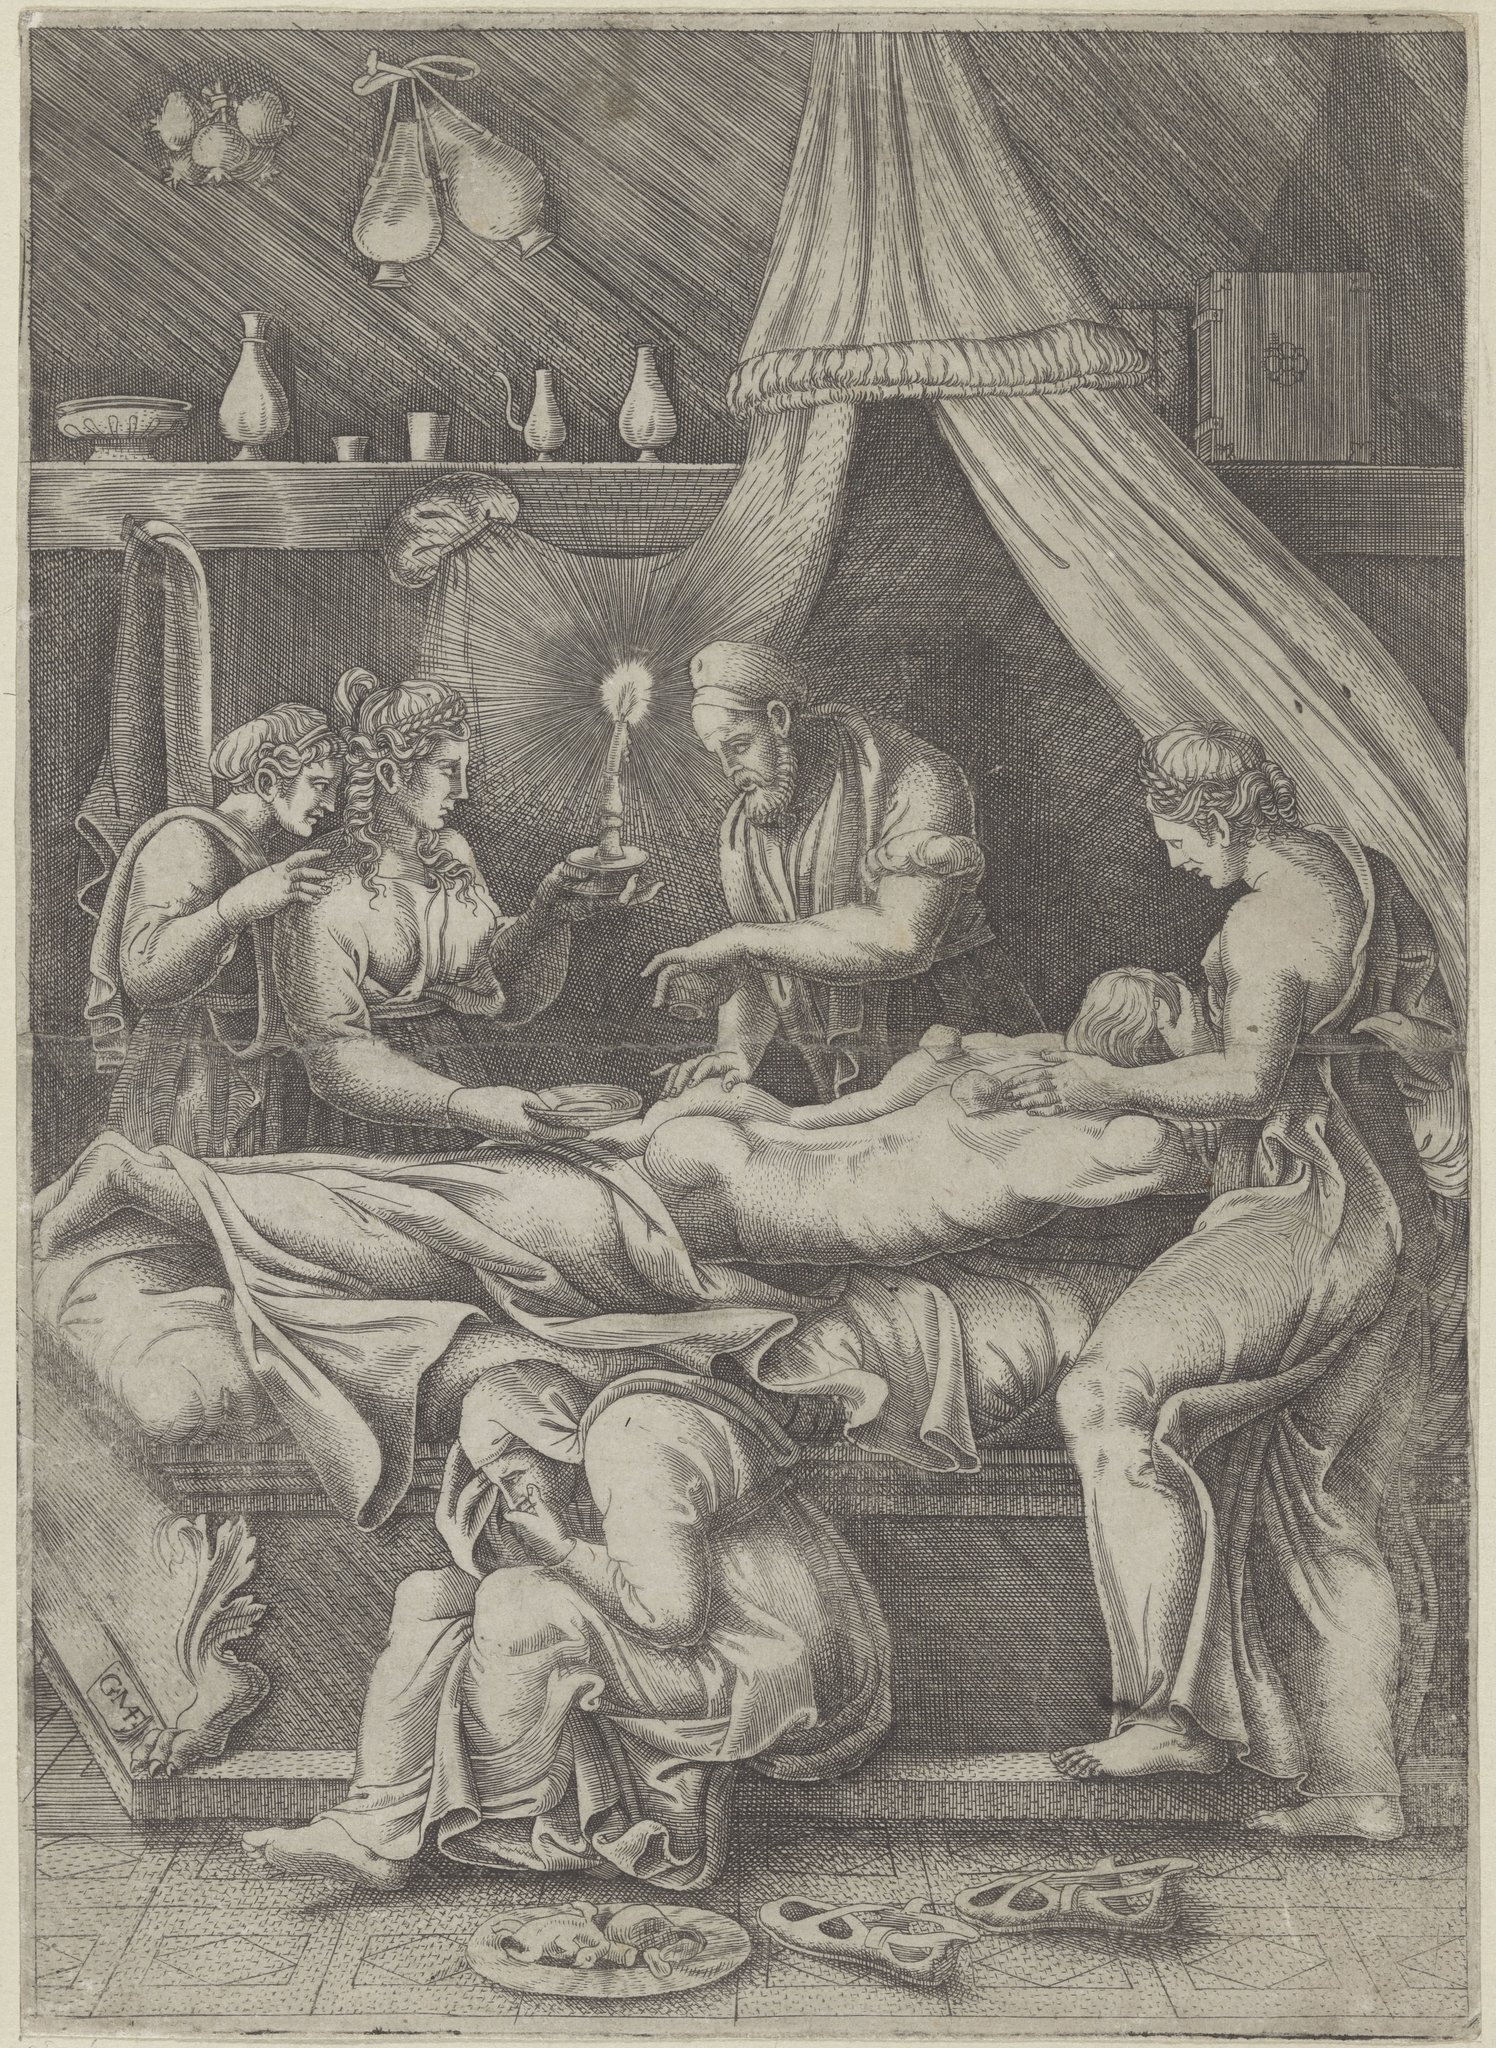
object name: print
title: Allegorie van de Ziekte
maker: giorgio ghisi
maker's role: print maker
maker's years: 1520-1582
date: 1530-1582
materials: paper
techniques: engraving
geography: mantua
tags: sick-bed, patient, sick person, healing of sick person, nursing, tending the sick, visiting the sick; sick person together with others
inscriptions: collector's mark: Lugt 240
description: Een zieke man ligt op bed met een laken over zijn benen. Achter het bed staan een oude en een jonge man en een jonge vrouw met een kaars. Een vrouw bij het hoofdeinde van het bed raakt de zieke man aan op zijn hoofd en rug. Een figuur met omslagdoek zit op de rand van het bed.